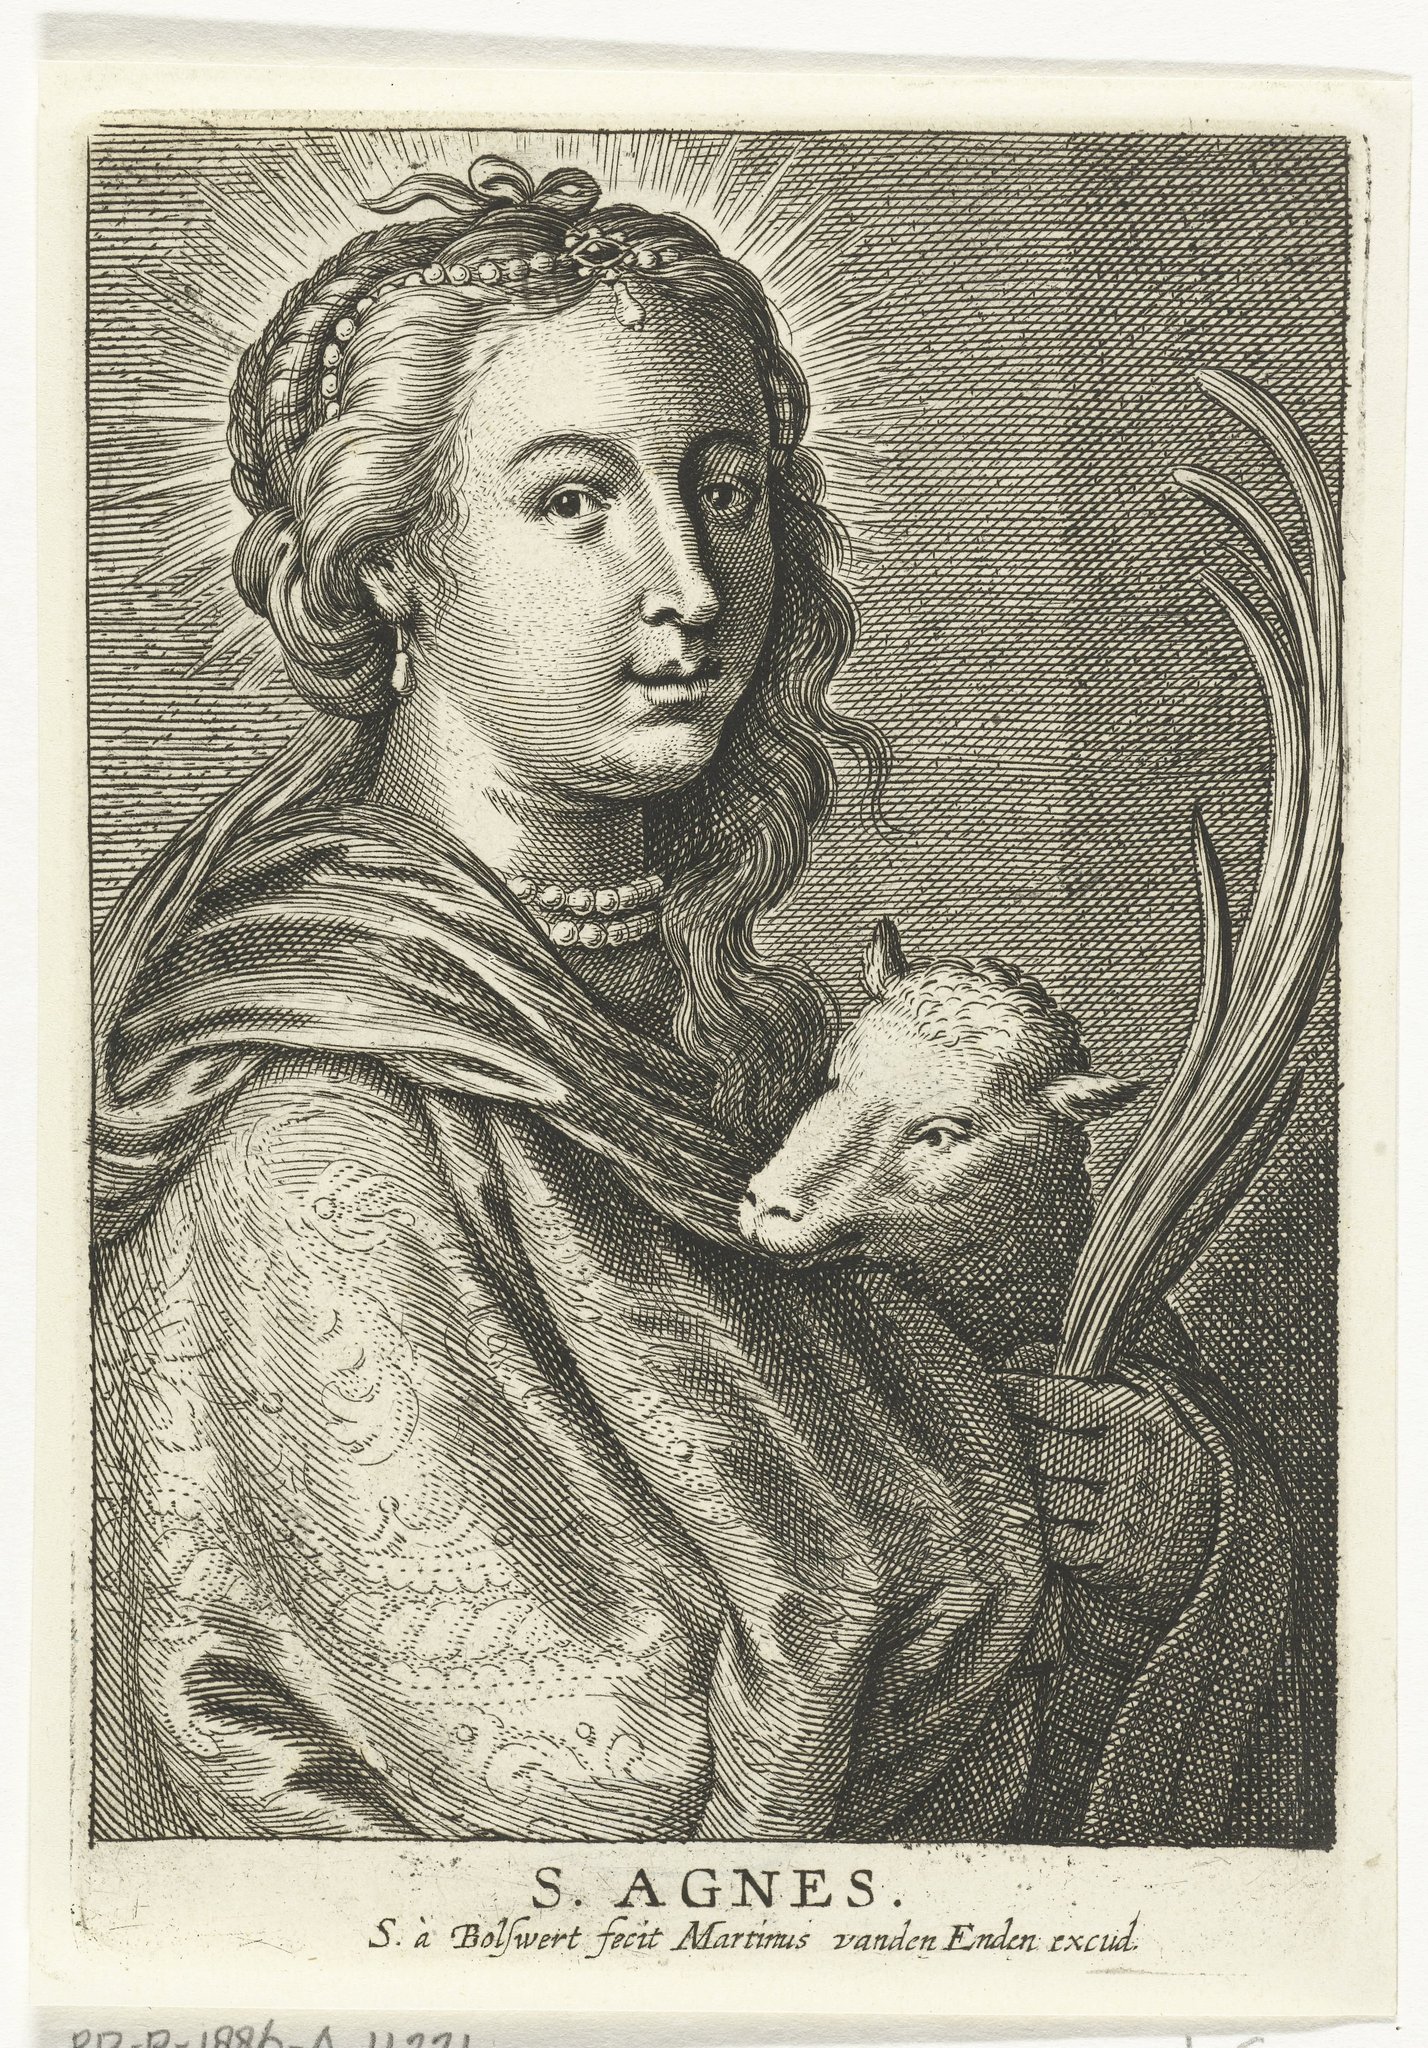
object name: print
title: S. Agnes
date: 1596-1659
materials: paper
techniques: engraving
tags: the virgin martyr agnes of rome; possible attributes: lamb, ring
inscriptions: collector's mark: Lugt 2228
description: Prent naar ontwerp van Peter Paul Rubens.